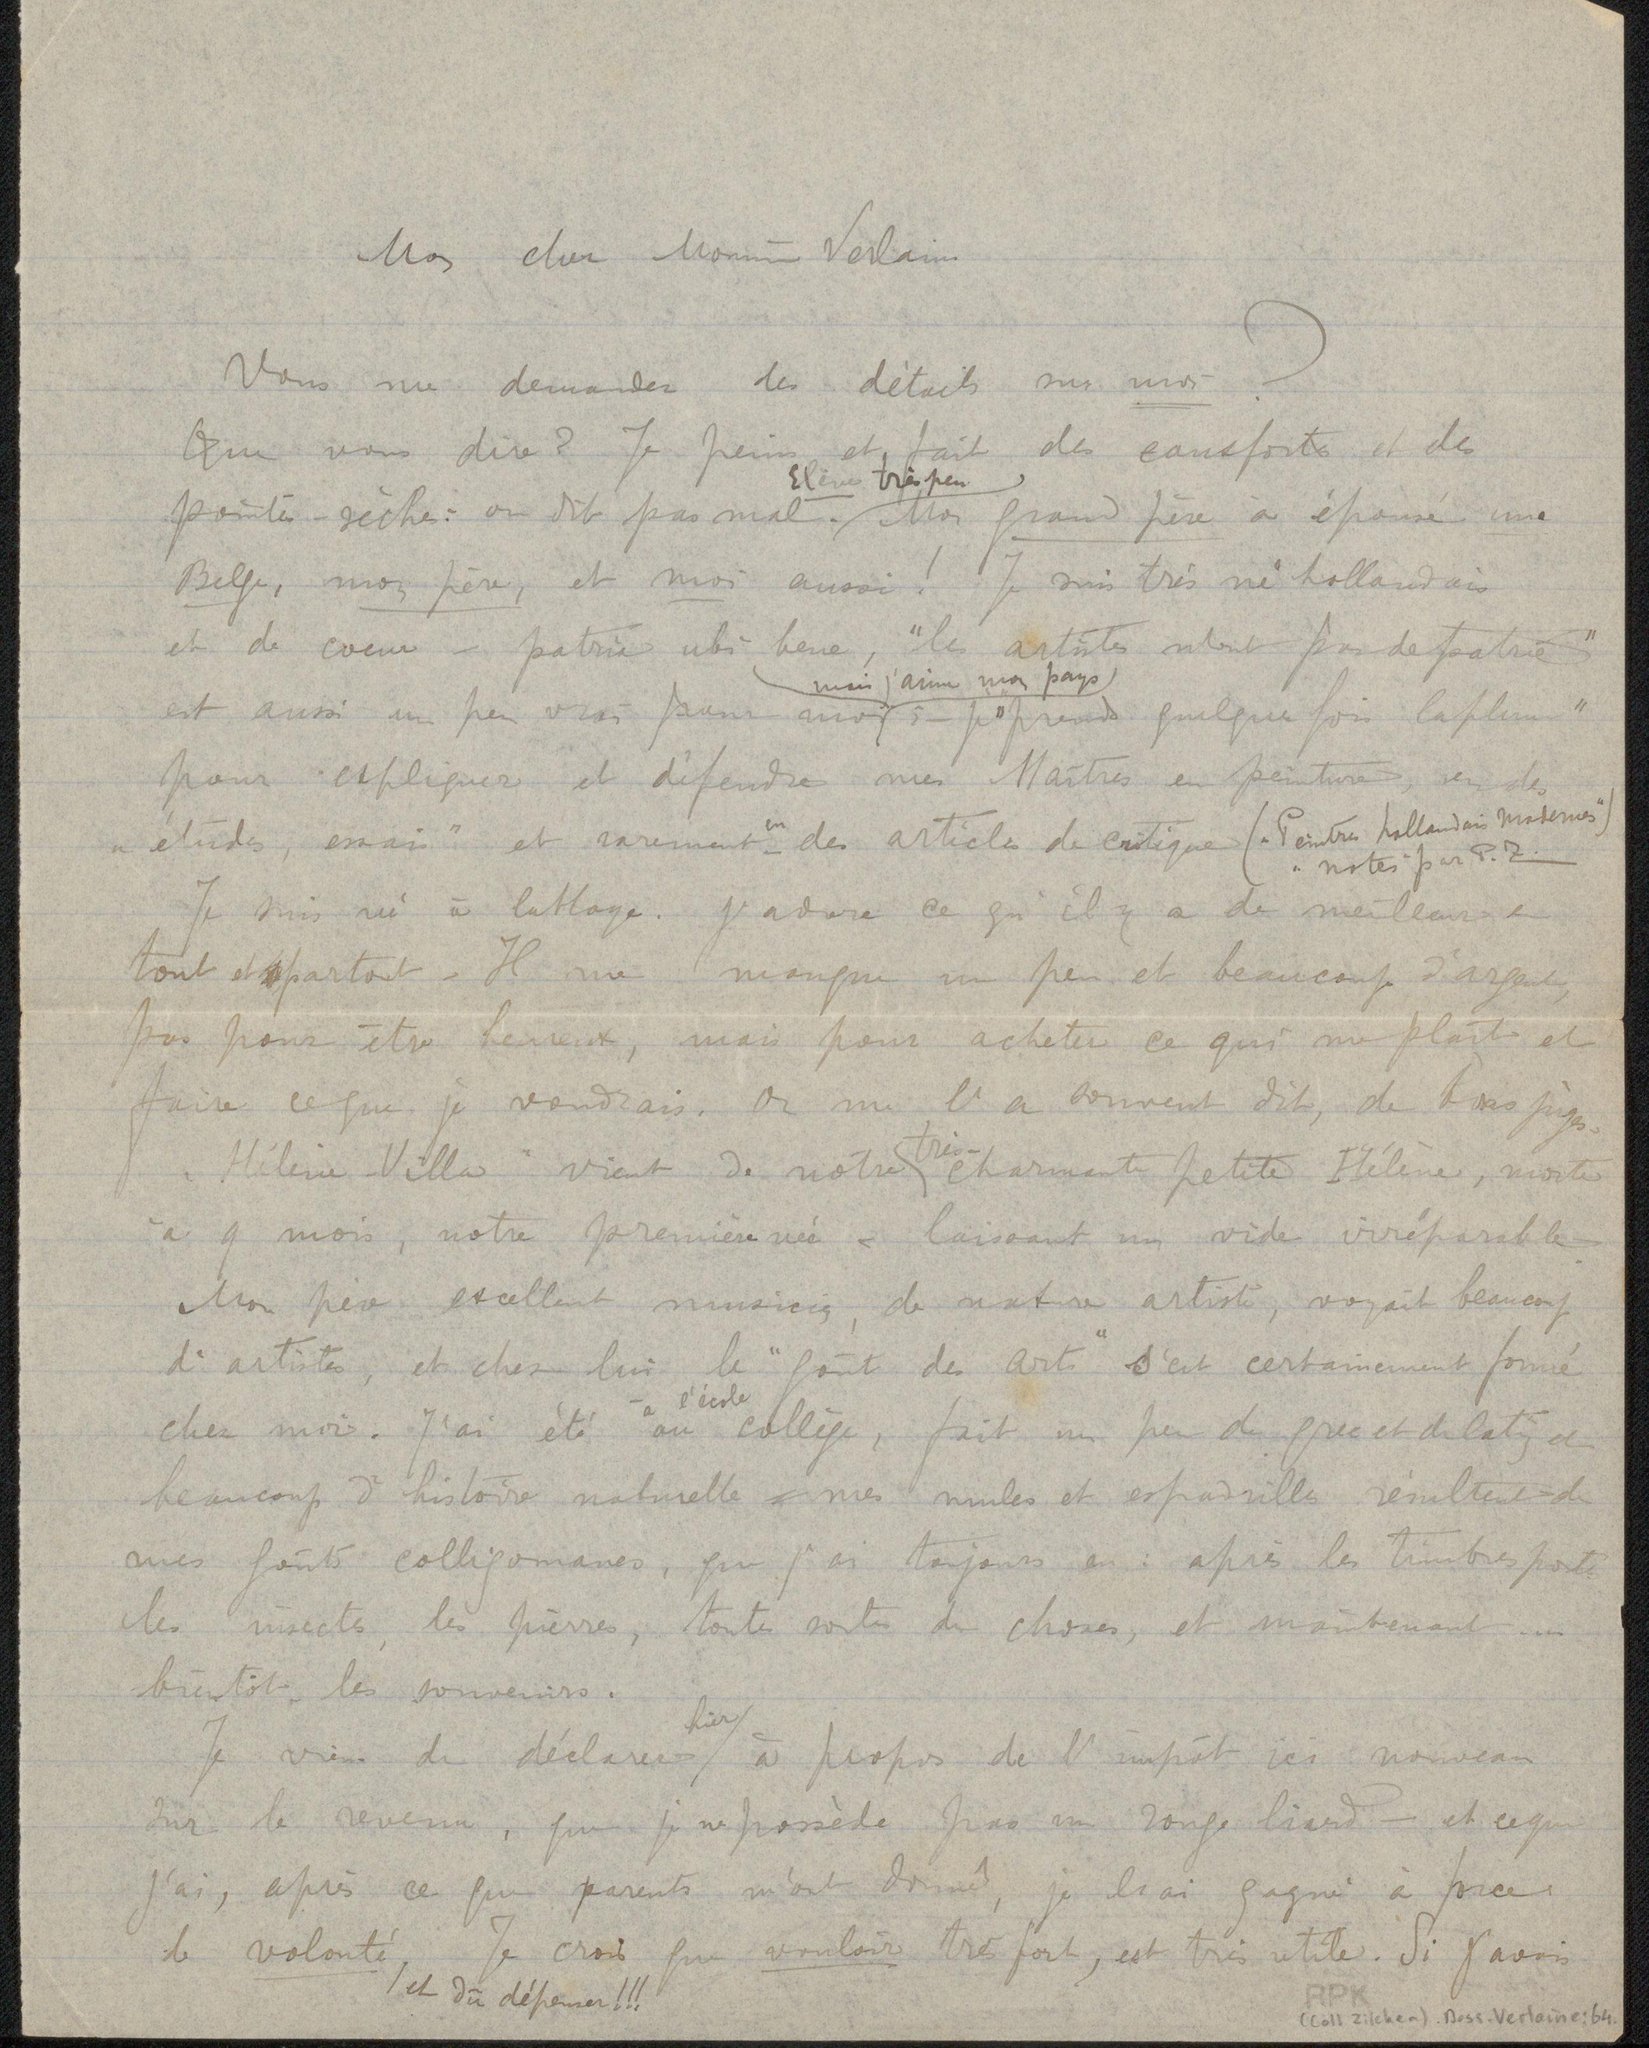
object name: letter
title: Brief aan Paul Verlaine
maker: philip zilcken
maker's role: draughtsman, painter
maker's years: 1857-1930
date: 1867-1896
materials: ink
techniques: pen, writing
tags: paris, paul verlaine, gustave flaubert, félix fénéon, the graphic arts, family life, amsterdam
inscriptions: collector's mark: ‘RPK’